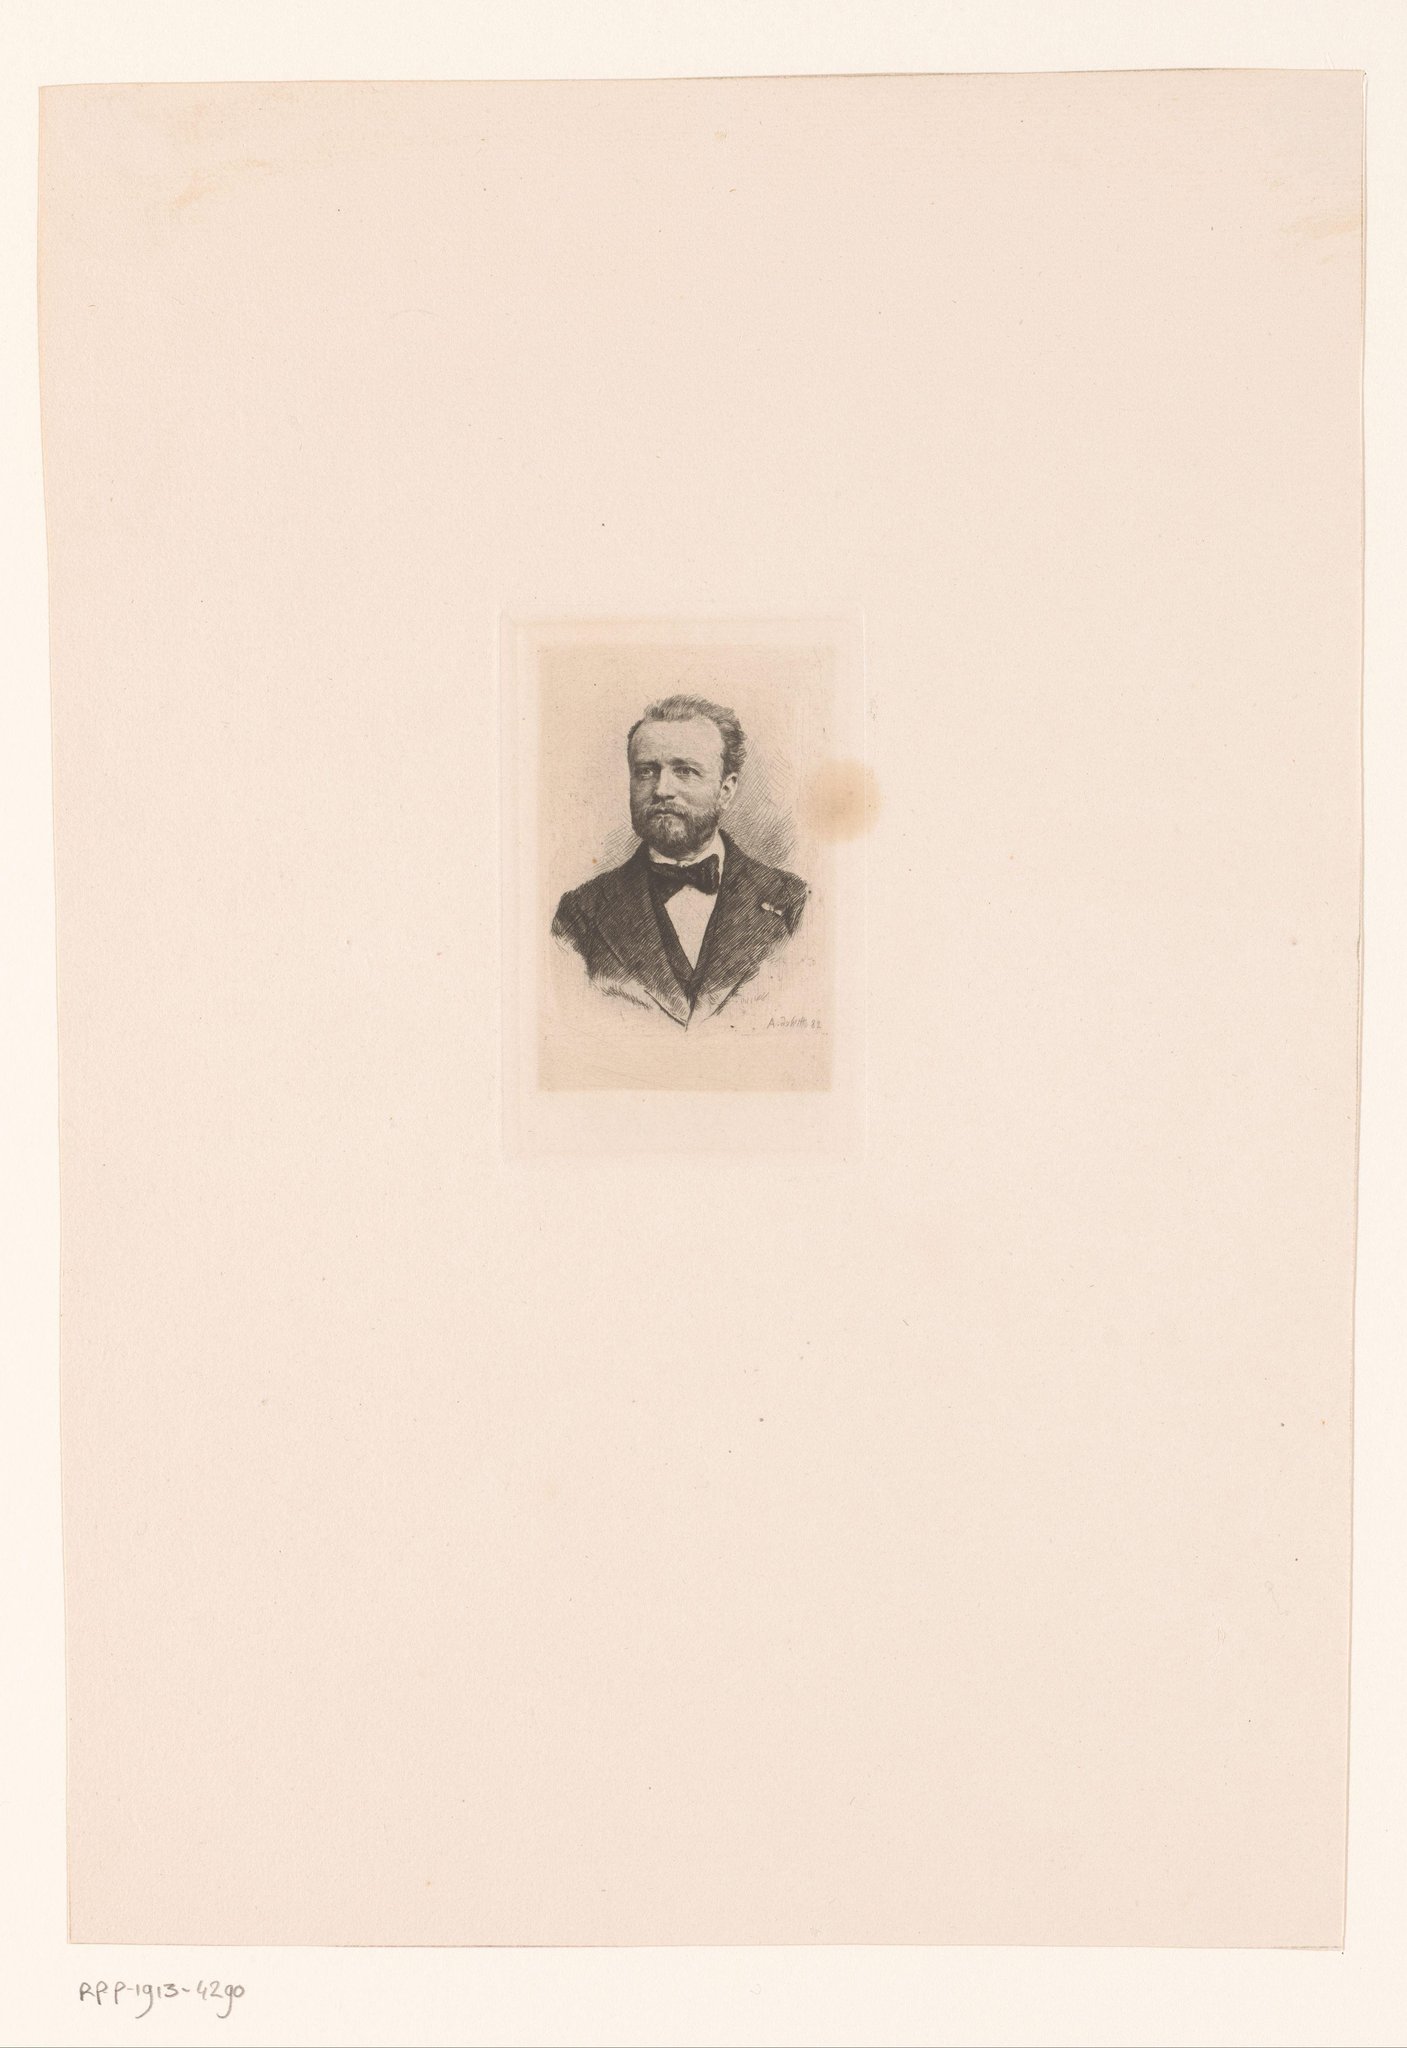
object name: print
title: Portret van Emmanuel Desoer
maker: adrien de witte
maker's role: print maker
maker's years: 1850-1935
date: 1882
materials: paper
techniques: drypoint, etching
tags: adult man, historical persons, beard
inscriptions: collector's mark: Lugt 2228